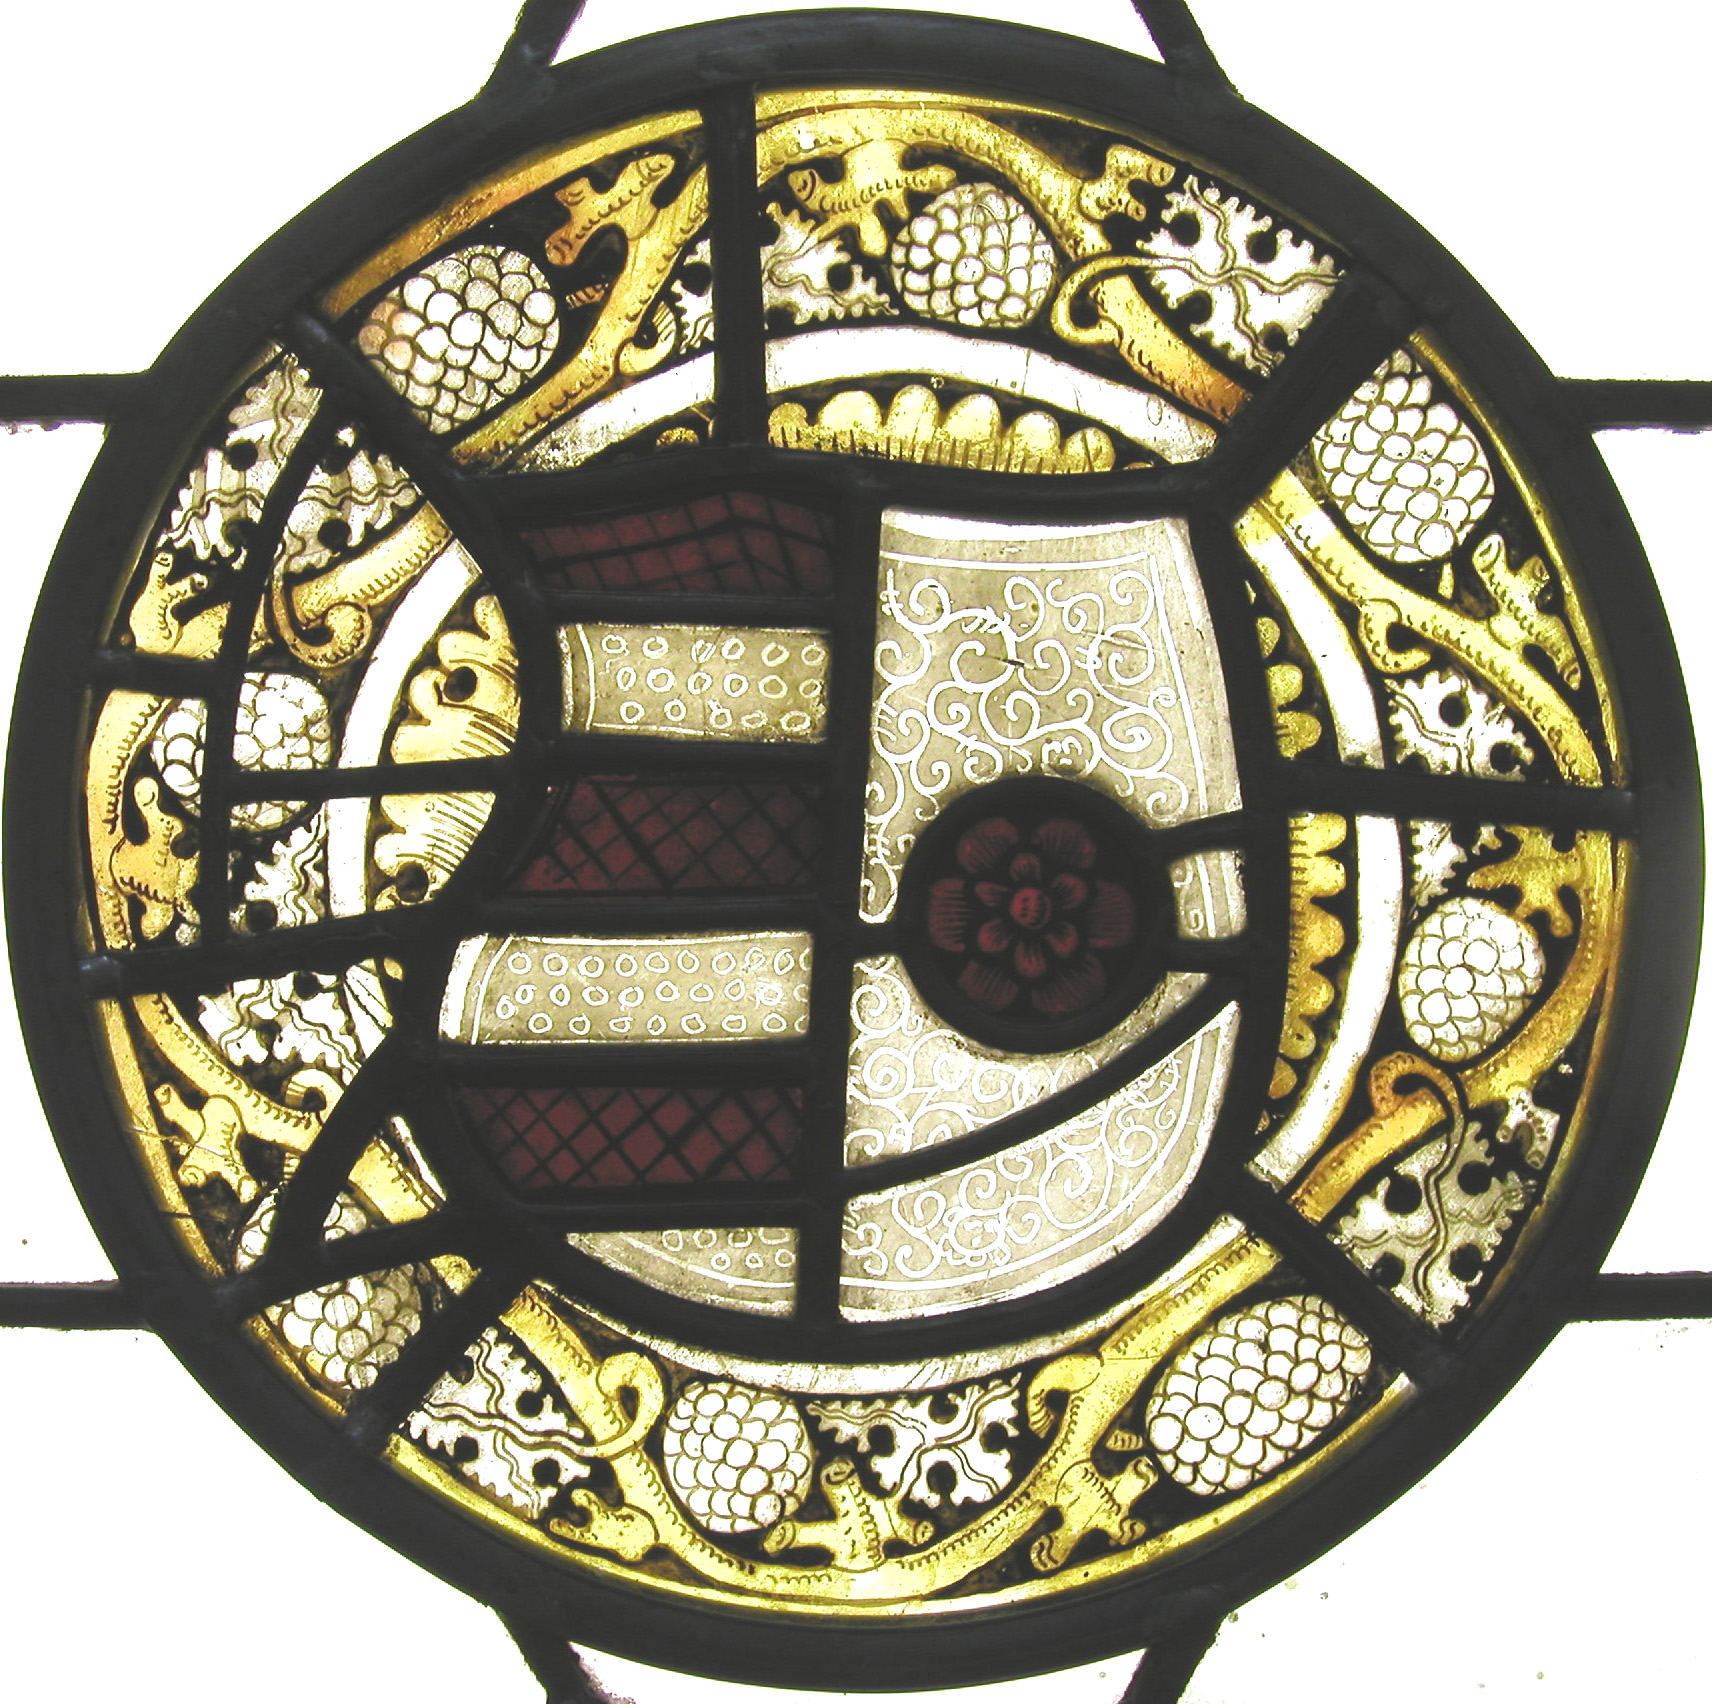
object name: roundel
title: Armorial Roundel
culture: german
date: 1500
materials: glass, metal, paint, pigment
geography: germany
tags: coat of arms